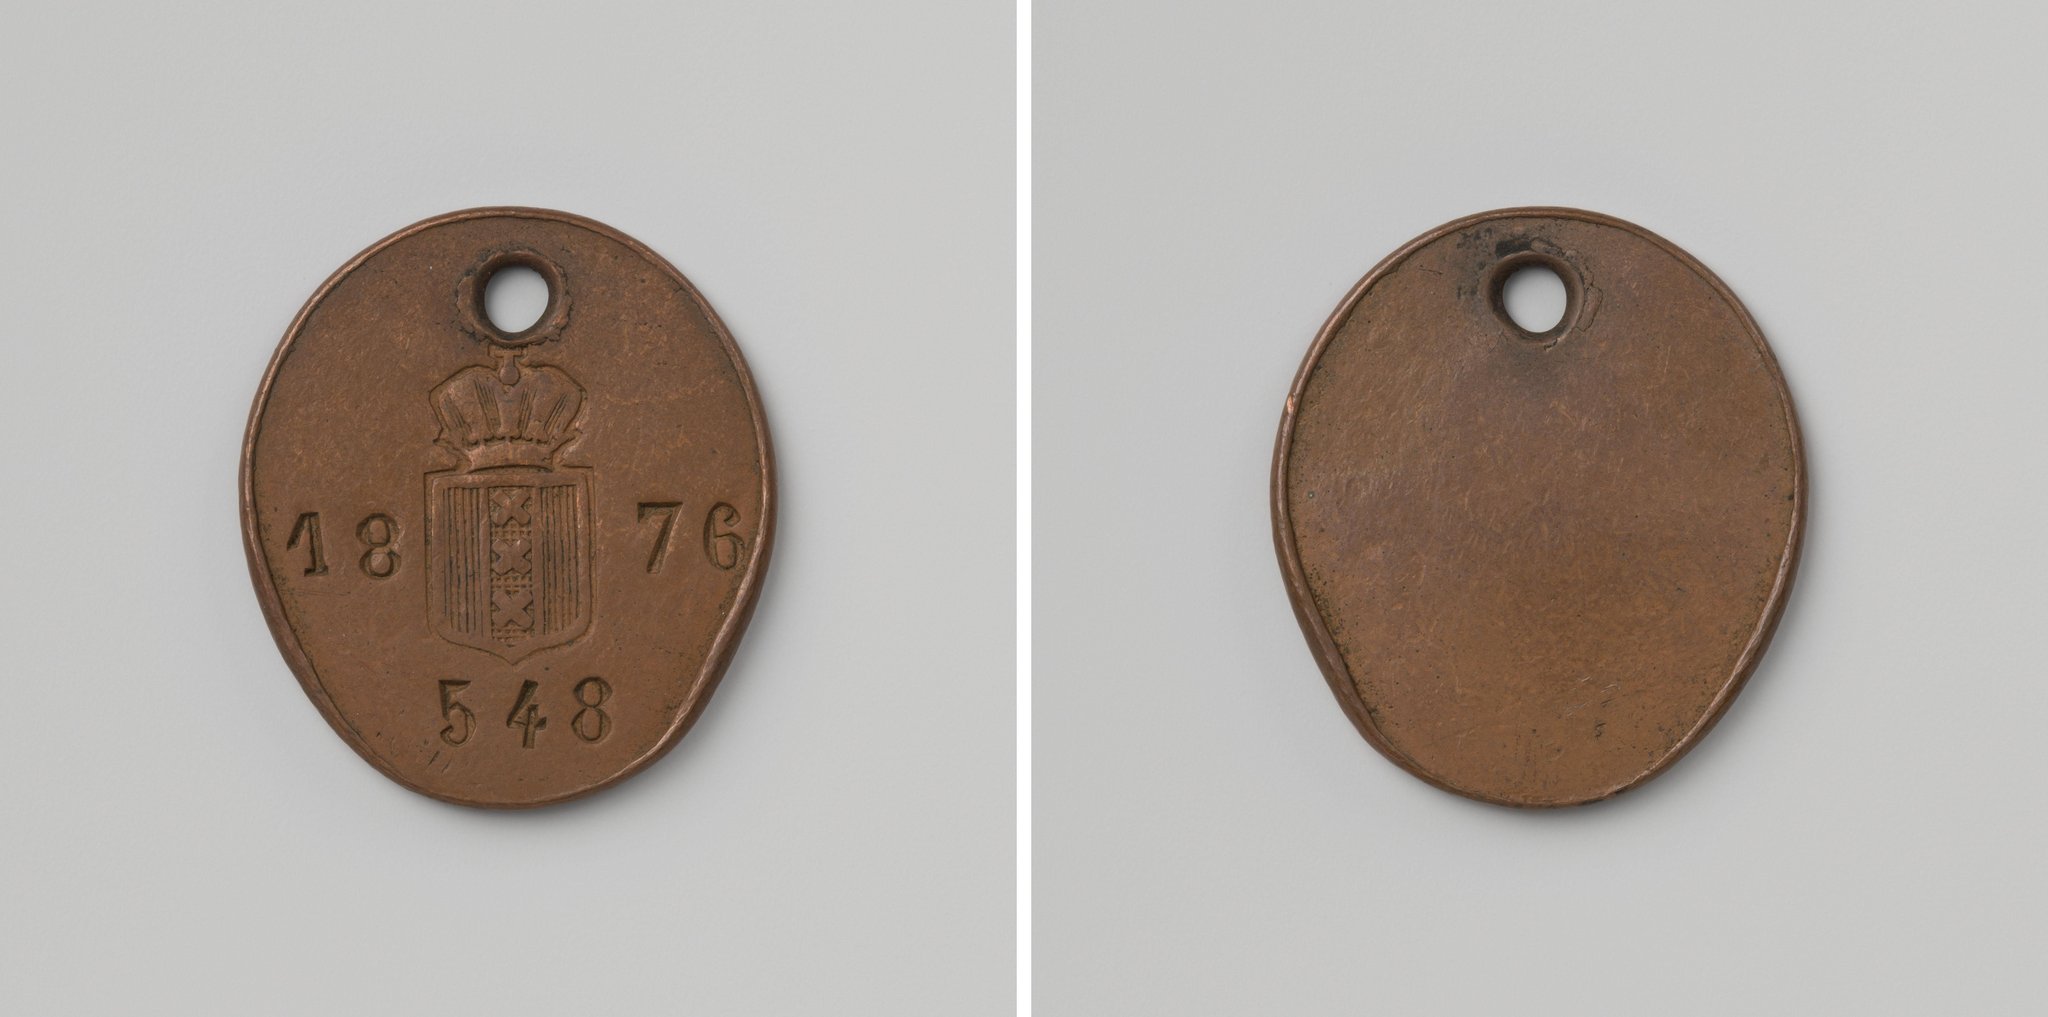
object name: tax token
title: Stad Amsterdam, loodje met no. 548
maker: Anonymous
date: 1876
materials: copper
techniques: striking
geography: amsterdam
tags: amsterdam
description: eenzijdig, enigszins ovaal loodje met gat erin. Voorzijde: gekroond wapenschild tussen jaartal boven cijfer 548. Keerzijde: blanco